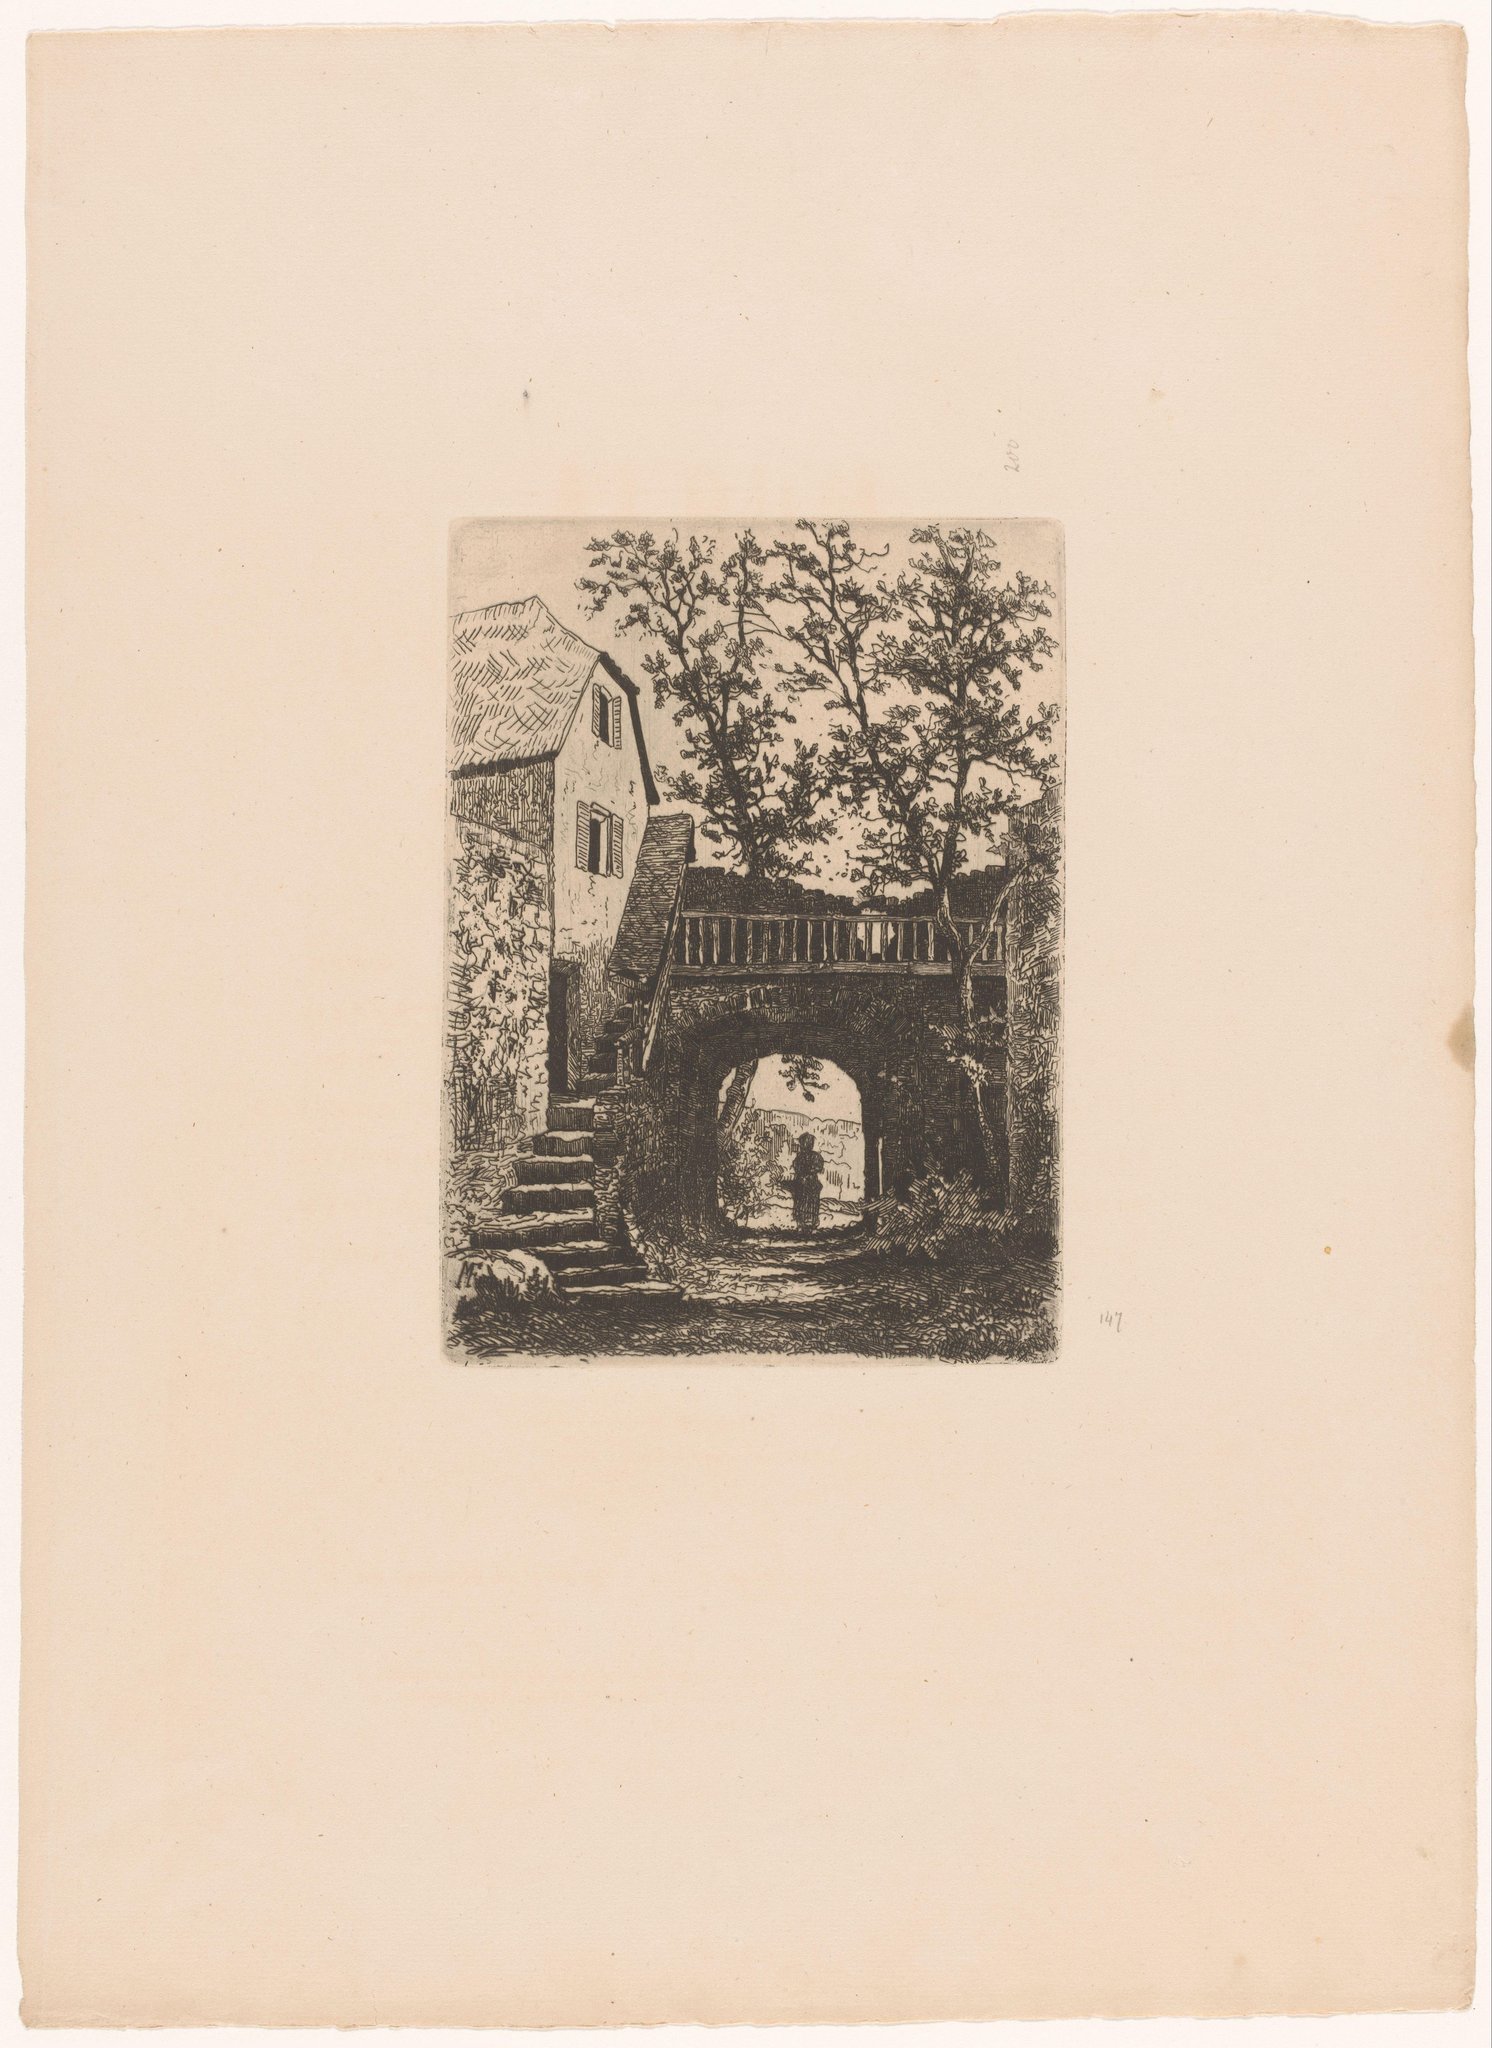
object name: print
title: Huis met trap erlangs bij een poort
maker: maria van hohenzollern-sigmaringen (gravin van vlaanderen)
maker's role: print maker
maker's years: 1845-1912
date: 1855-1880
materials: paper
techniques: etching, intaglio, retroussage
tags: housing, village-gate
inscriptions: collector's mark: Lugt 2228